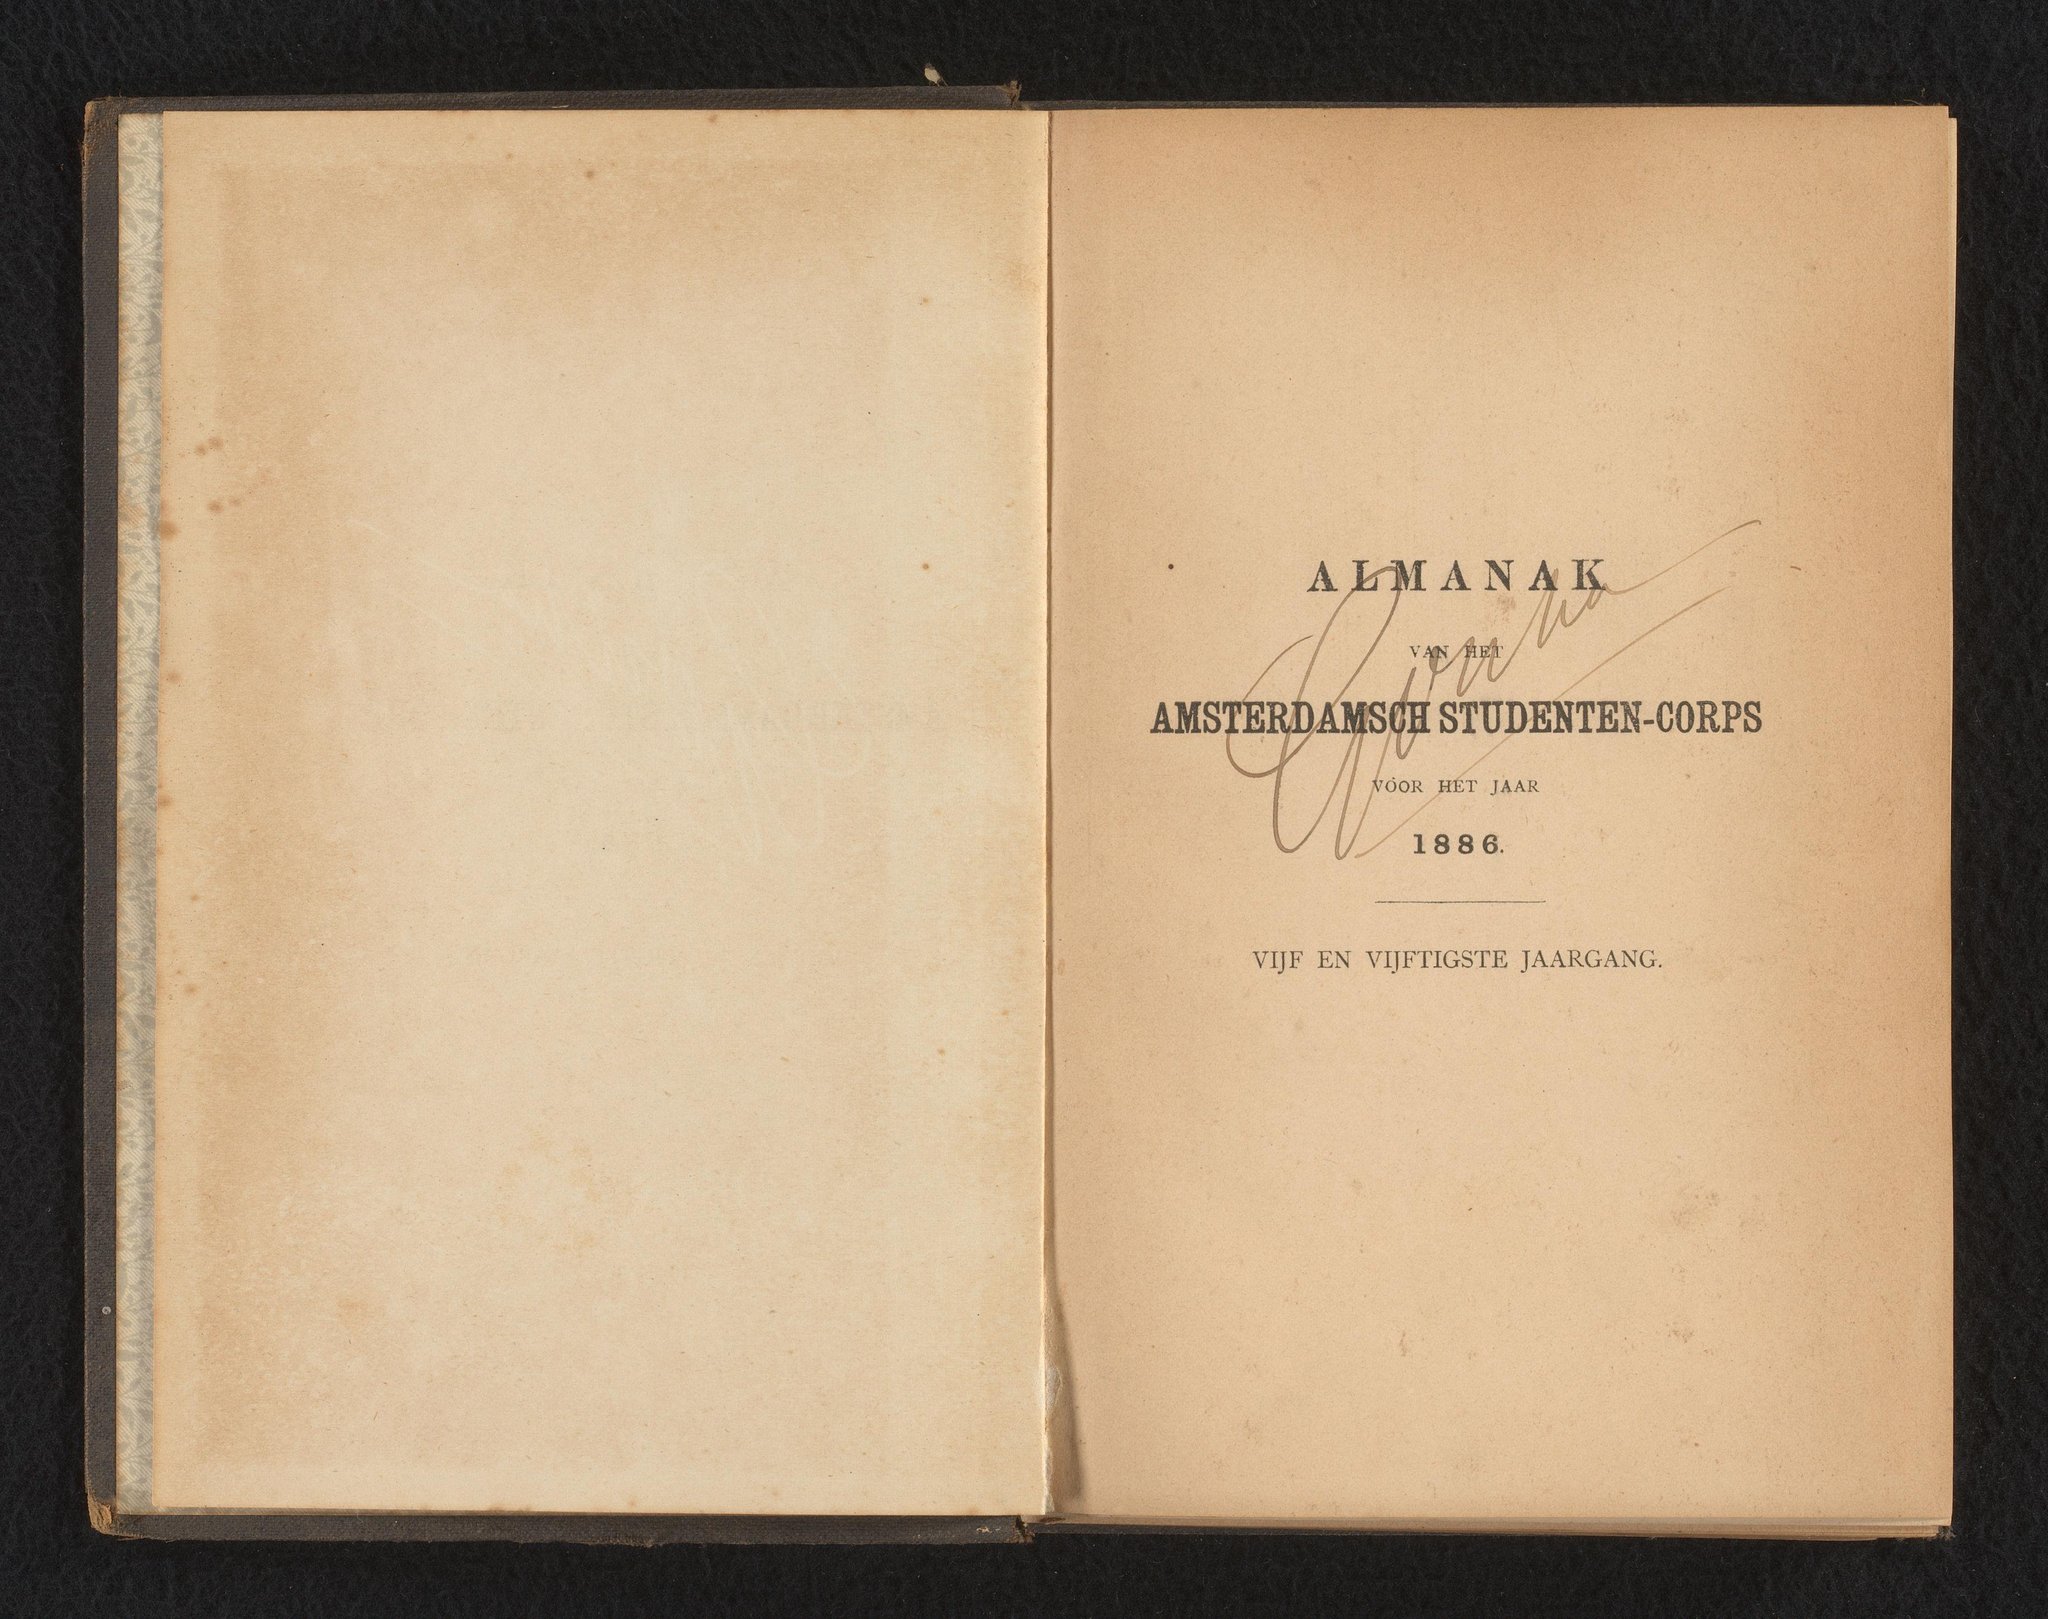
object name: book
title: Almanak van het Amsterdamsch studenten-corps voor het jaar 1886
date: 1886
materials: paper, cardboard, linen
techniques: albumen print, engraving, letterpress printing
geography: amsterdam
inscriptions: number: ‘90099 702’, signature: ‘Gouhn [?]’